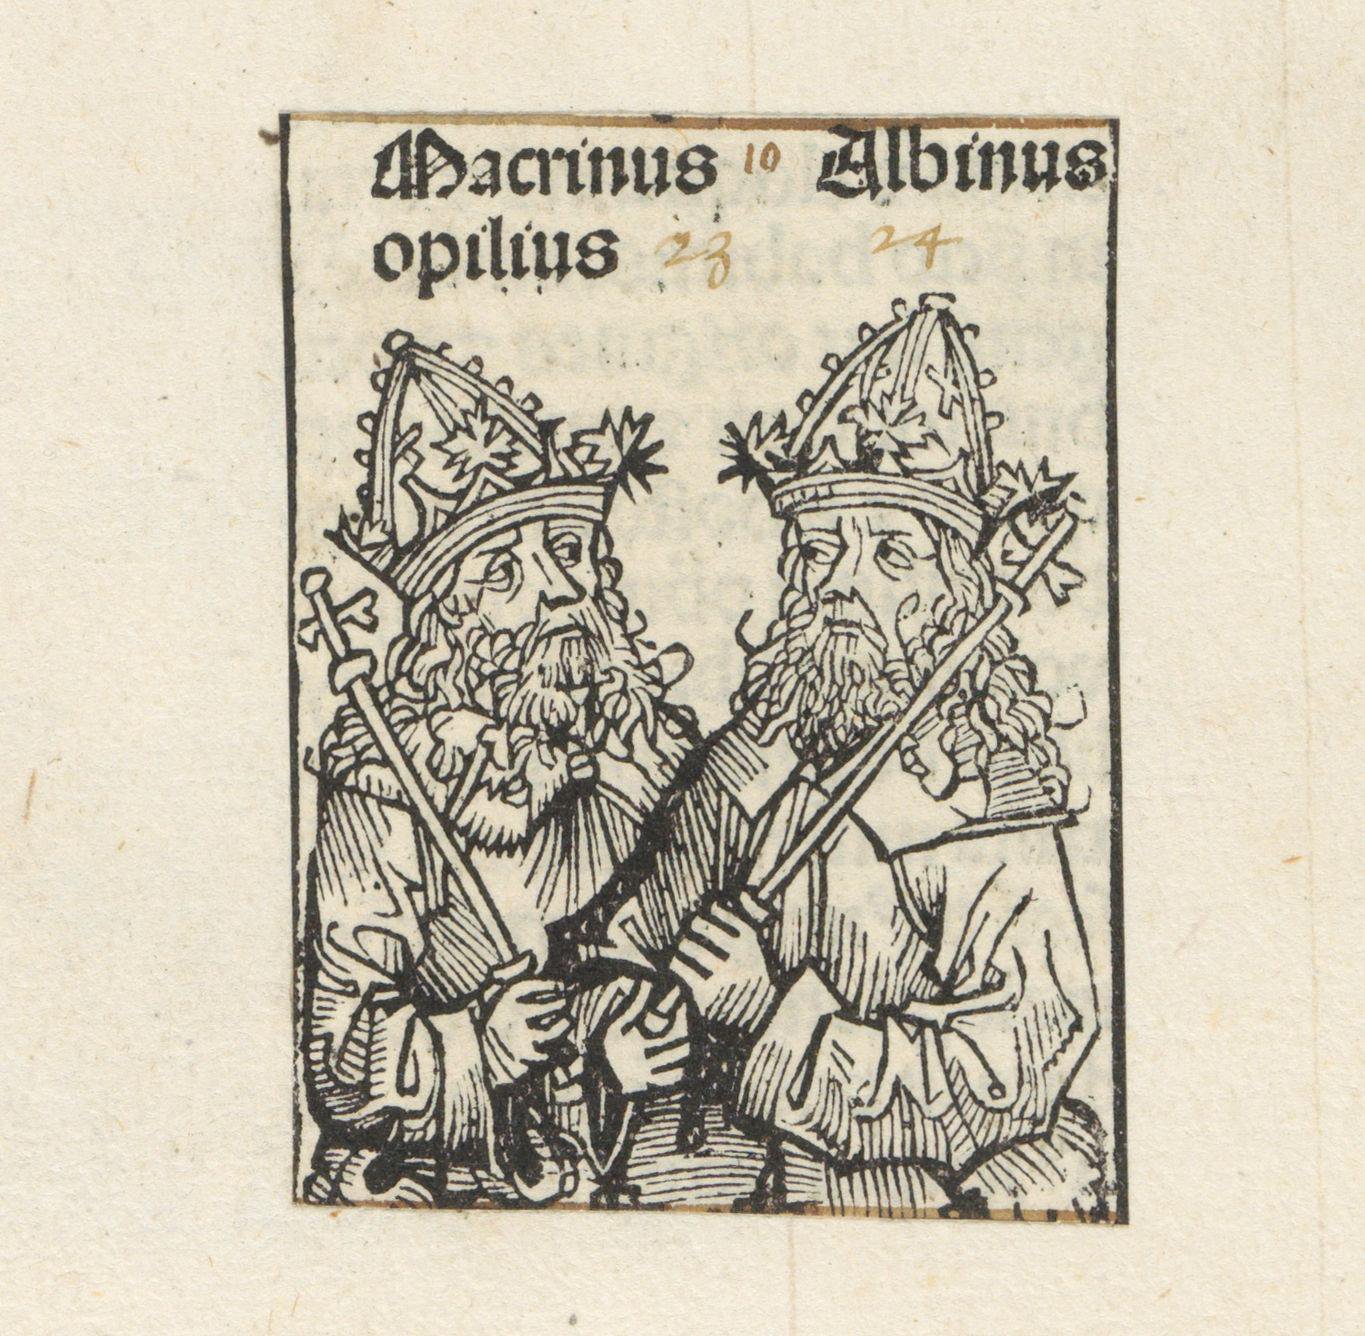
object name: book illustration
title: Liber Chronicarum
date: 1493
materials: paper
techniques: letterpress printing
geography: nuremberg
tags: emperor, king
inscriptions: inscription: ‘10 / 23 / 24’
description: Een bloemkelk met twee koningen, een scepter in hun handen. De voorstelling is onderdeel van de opeenvolging Romeinse keizers in de Liber Chronicarum. De tekst identificeert de mannen als keizer Macrinus en keizer Clodius Albinus. De prent maakt deel uit van een album.